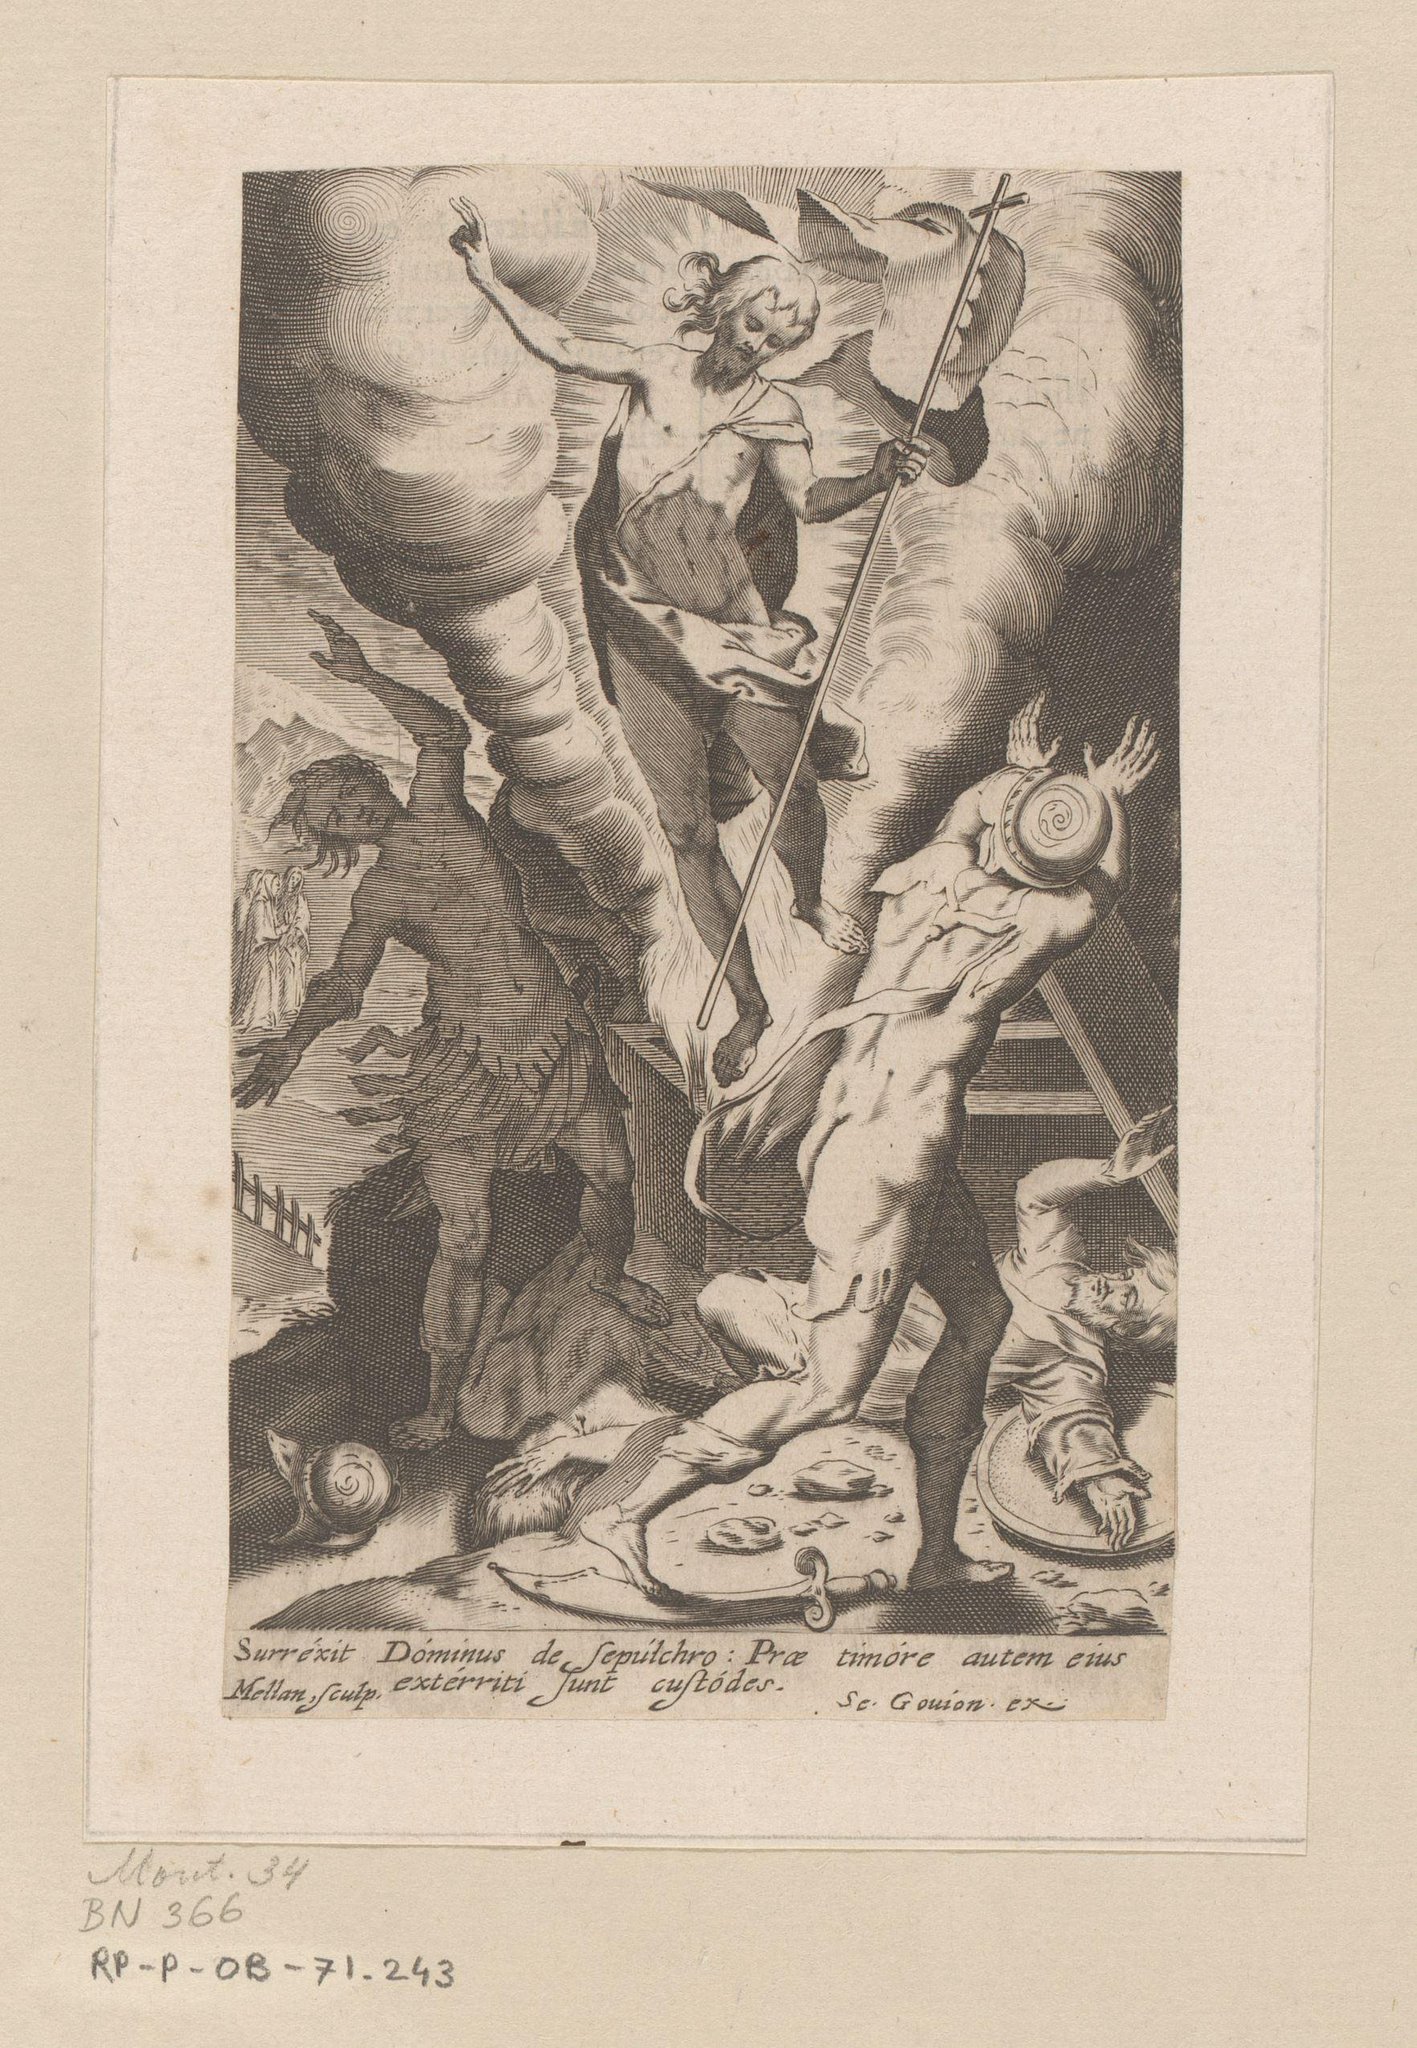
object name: print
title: Opstanding van Christus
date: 1619-1624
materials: paper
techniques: engraving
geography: paris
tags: christ, usually holding a banner, arises from the grave; often combined with sleeping and/or frightened soldiers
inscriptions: collector's mark: Lugt 240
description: Prent uit een onbekend boek, mogelijk een brevier voor Dominicanen.